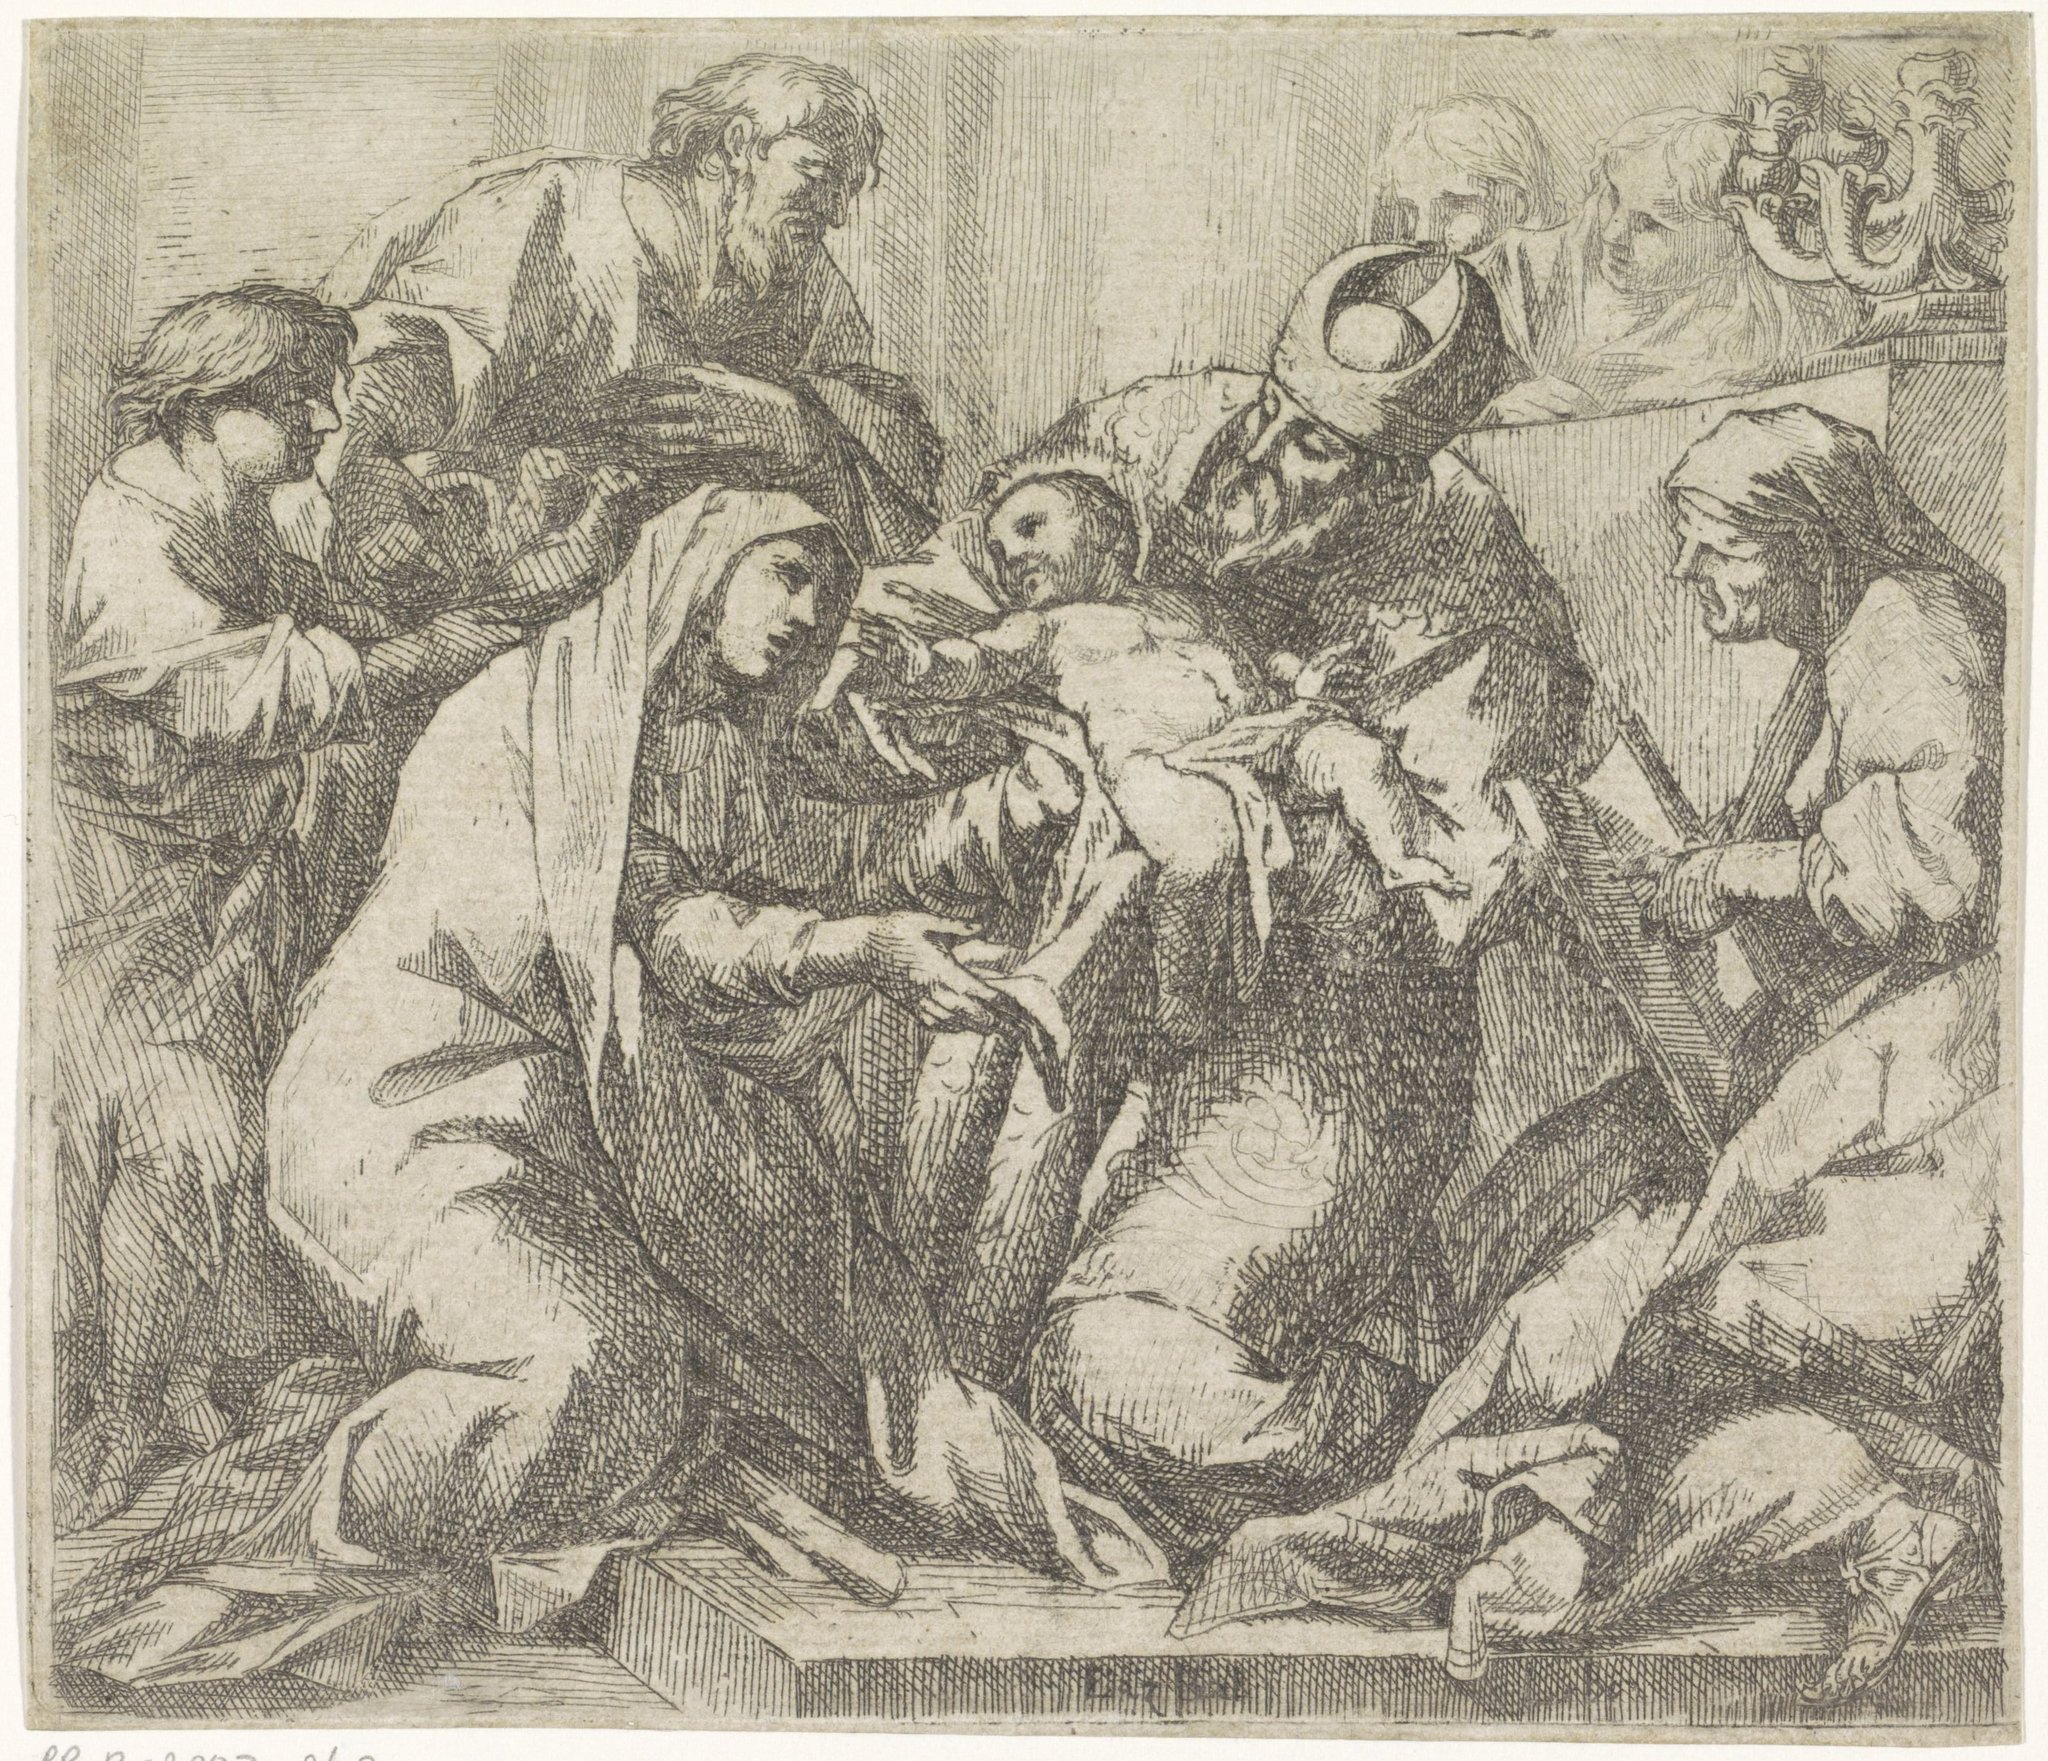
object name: print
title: Besnijdenis van Christus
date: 1650-1699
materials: paper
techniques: etching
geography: italy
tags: circumcision of the christ-child by the priest in the temple (luke 2:21)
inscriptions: collector's mark: Lugt 2228, collector's mark: Lugt 2760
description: Het Christuskind wordt vastgehouden door Maria en een priester. Jozef staat achter hen. Links een jongeman met twee duiven in de hand. Rechts een man met een boek.